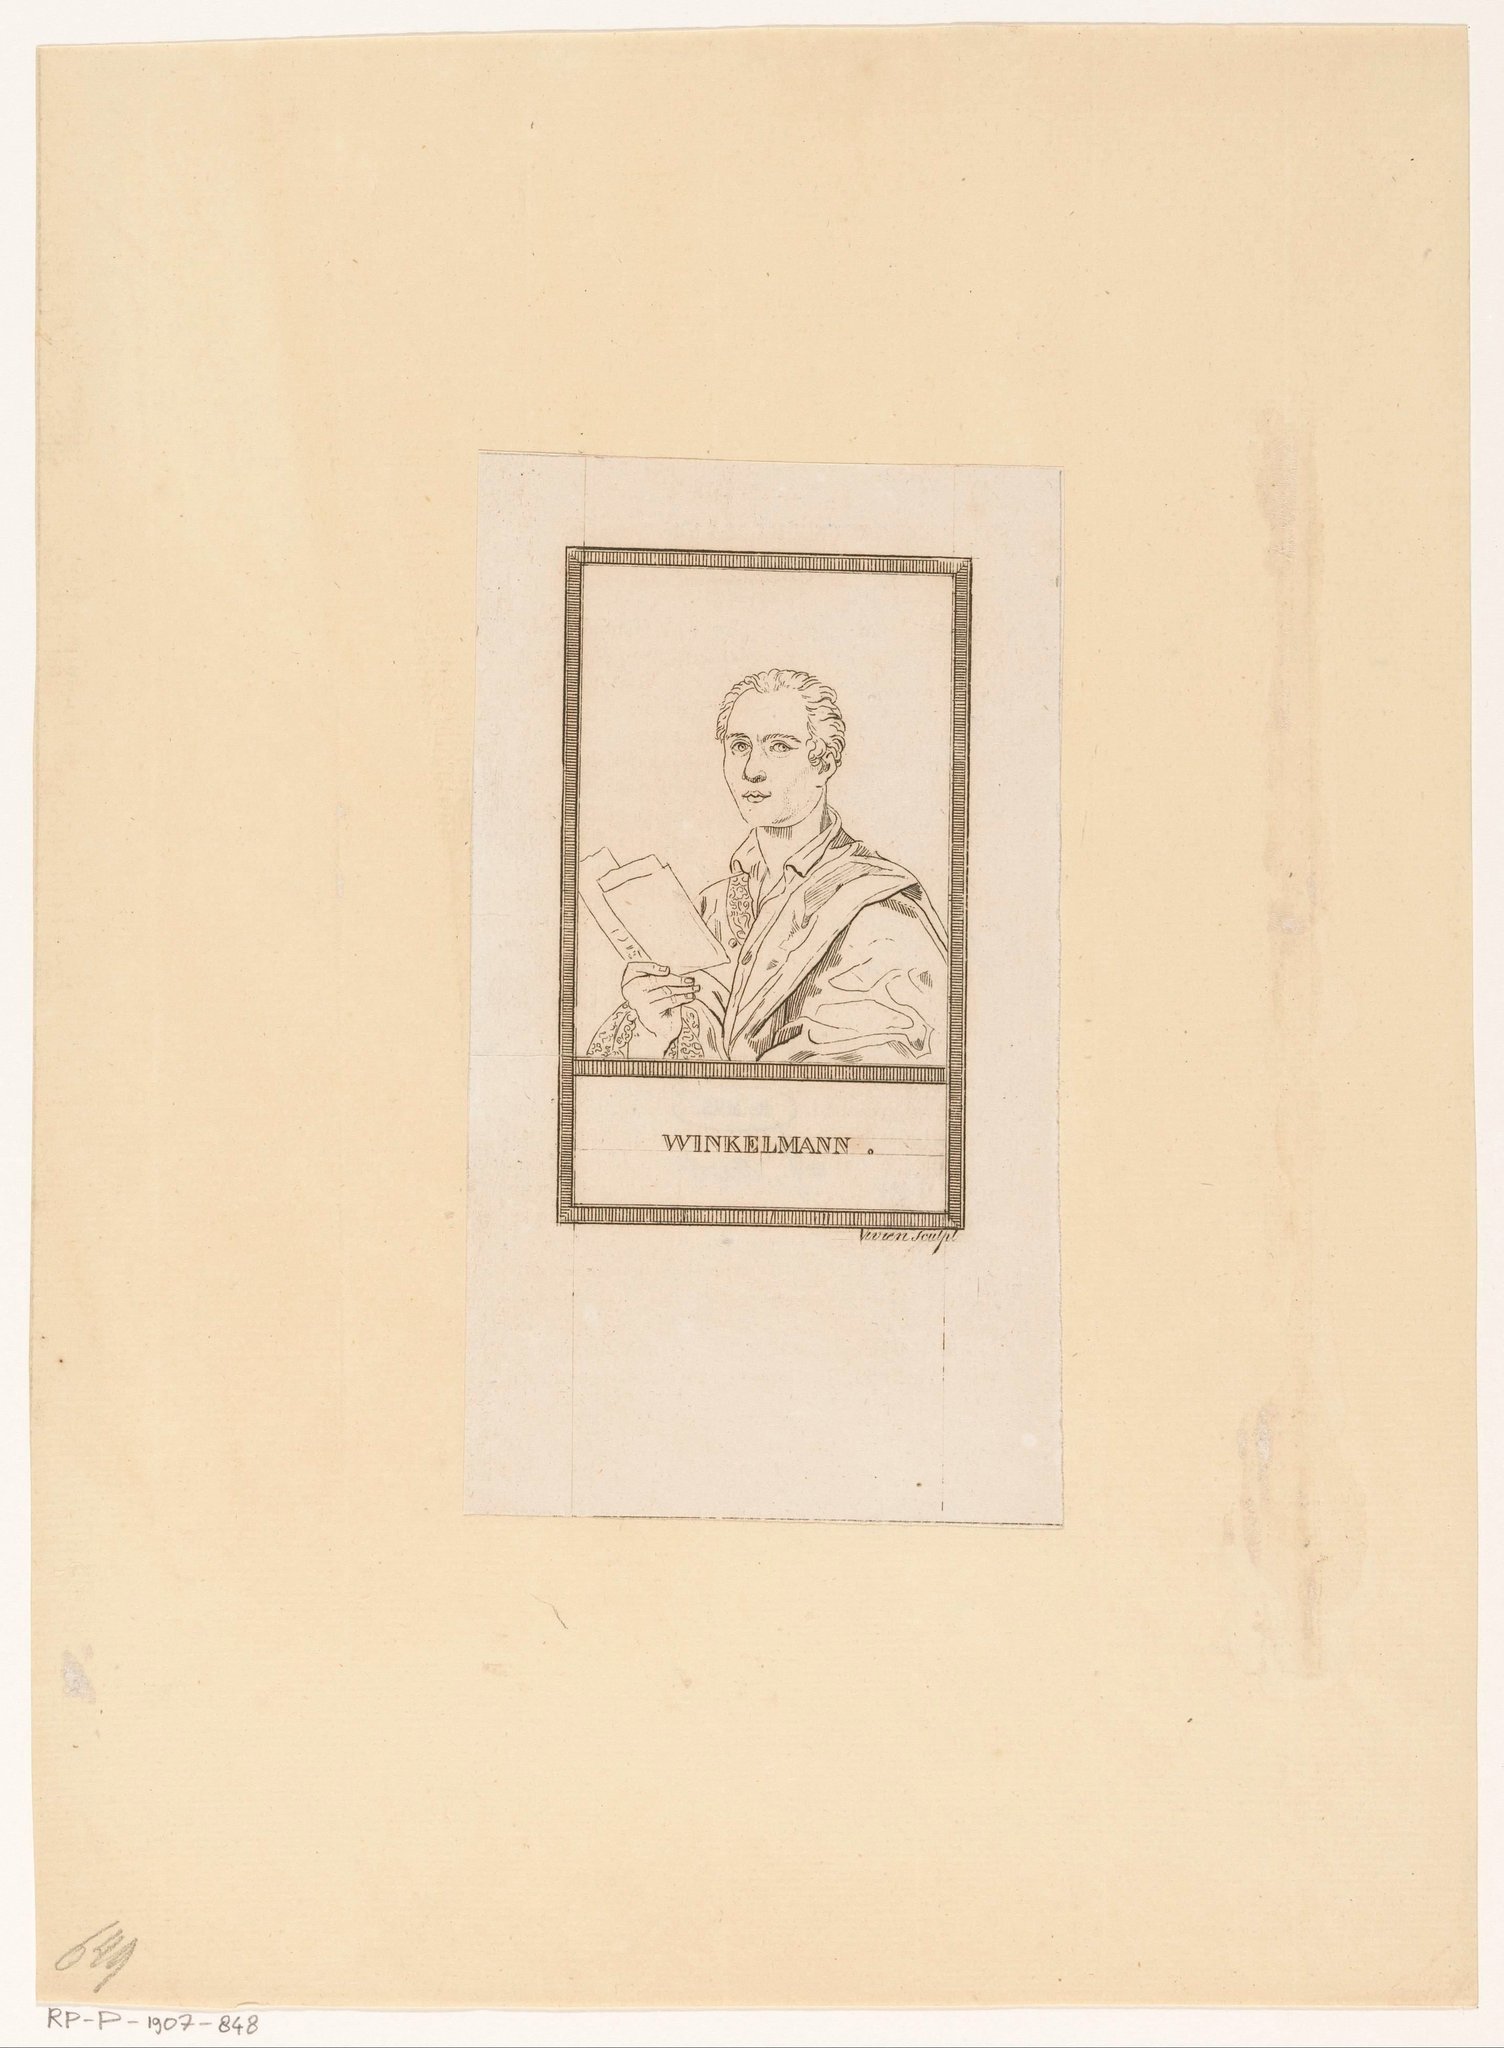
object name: print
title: Portret van Johann Joachim Winckelmann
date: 1805-1811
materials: paper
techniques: etching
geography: paris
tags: history and archaeology, historical persons, book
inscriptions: collector's mark: Lugt 2228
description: Mogelijk prent uit: Landon, Charles Paul. Galerie historique des hommes les plus celebres de tous les nations. (...). Parijs, Musée et l'école des beaux-arts,1805-1811.